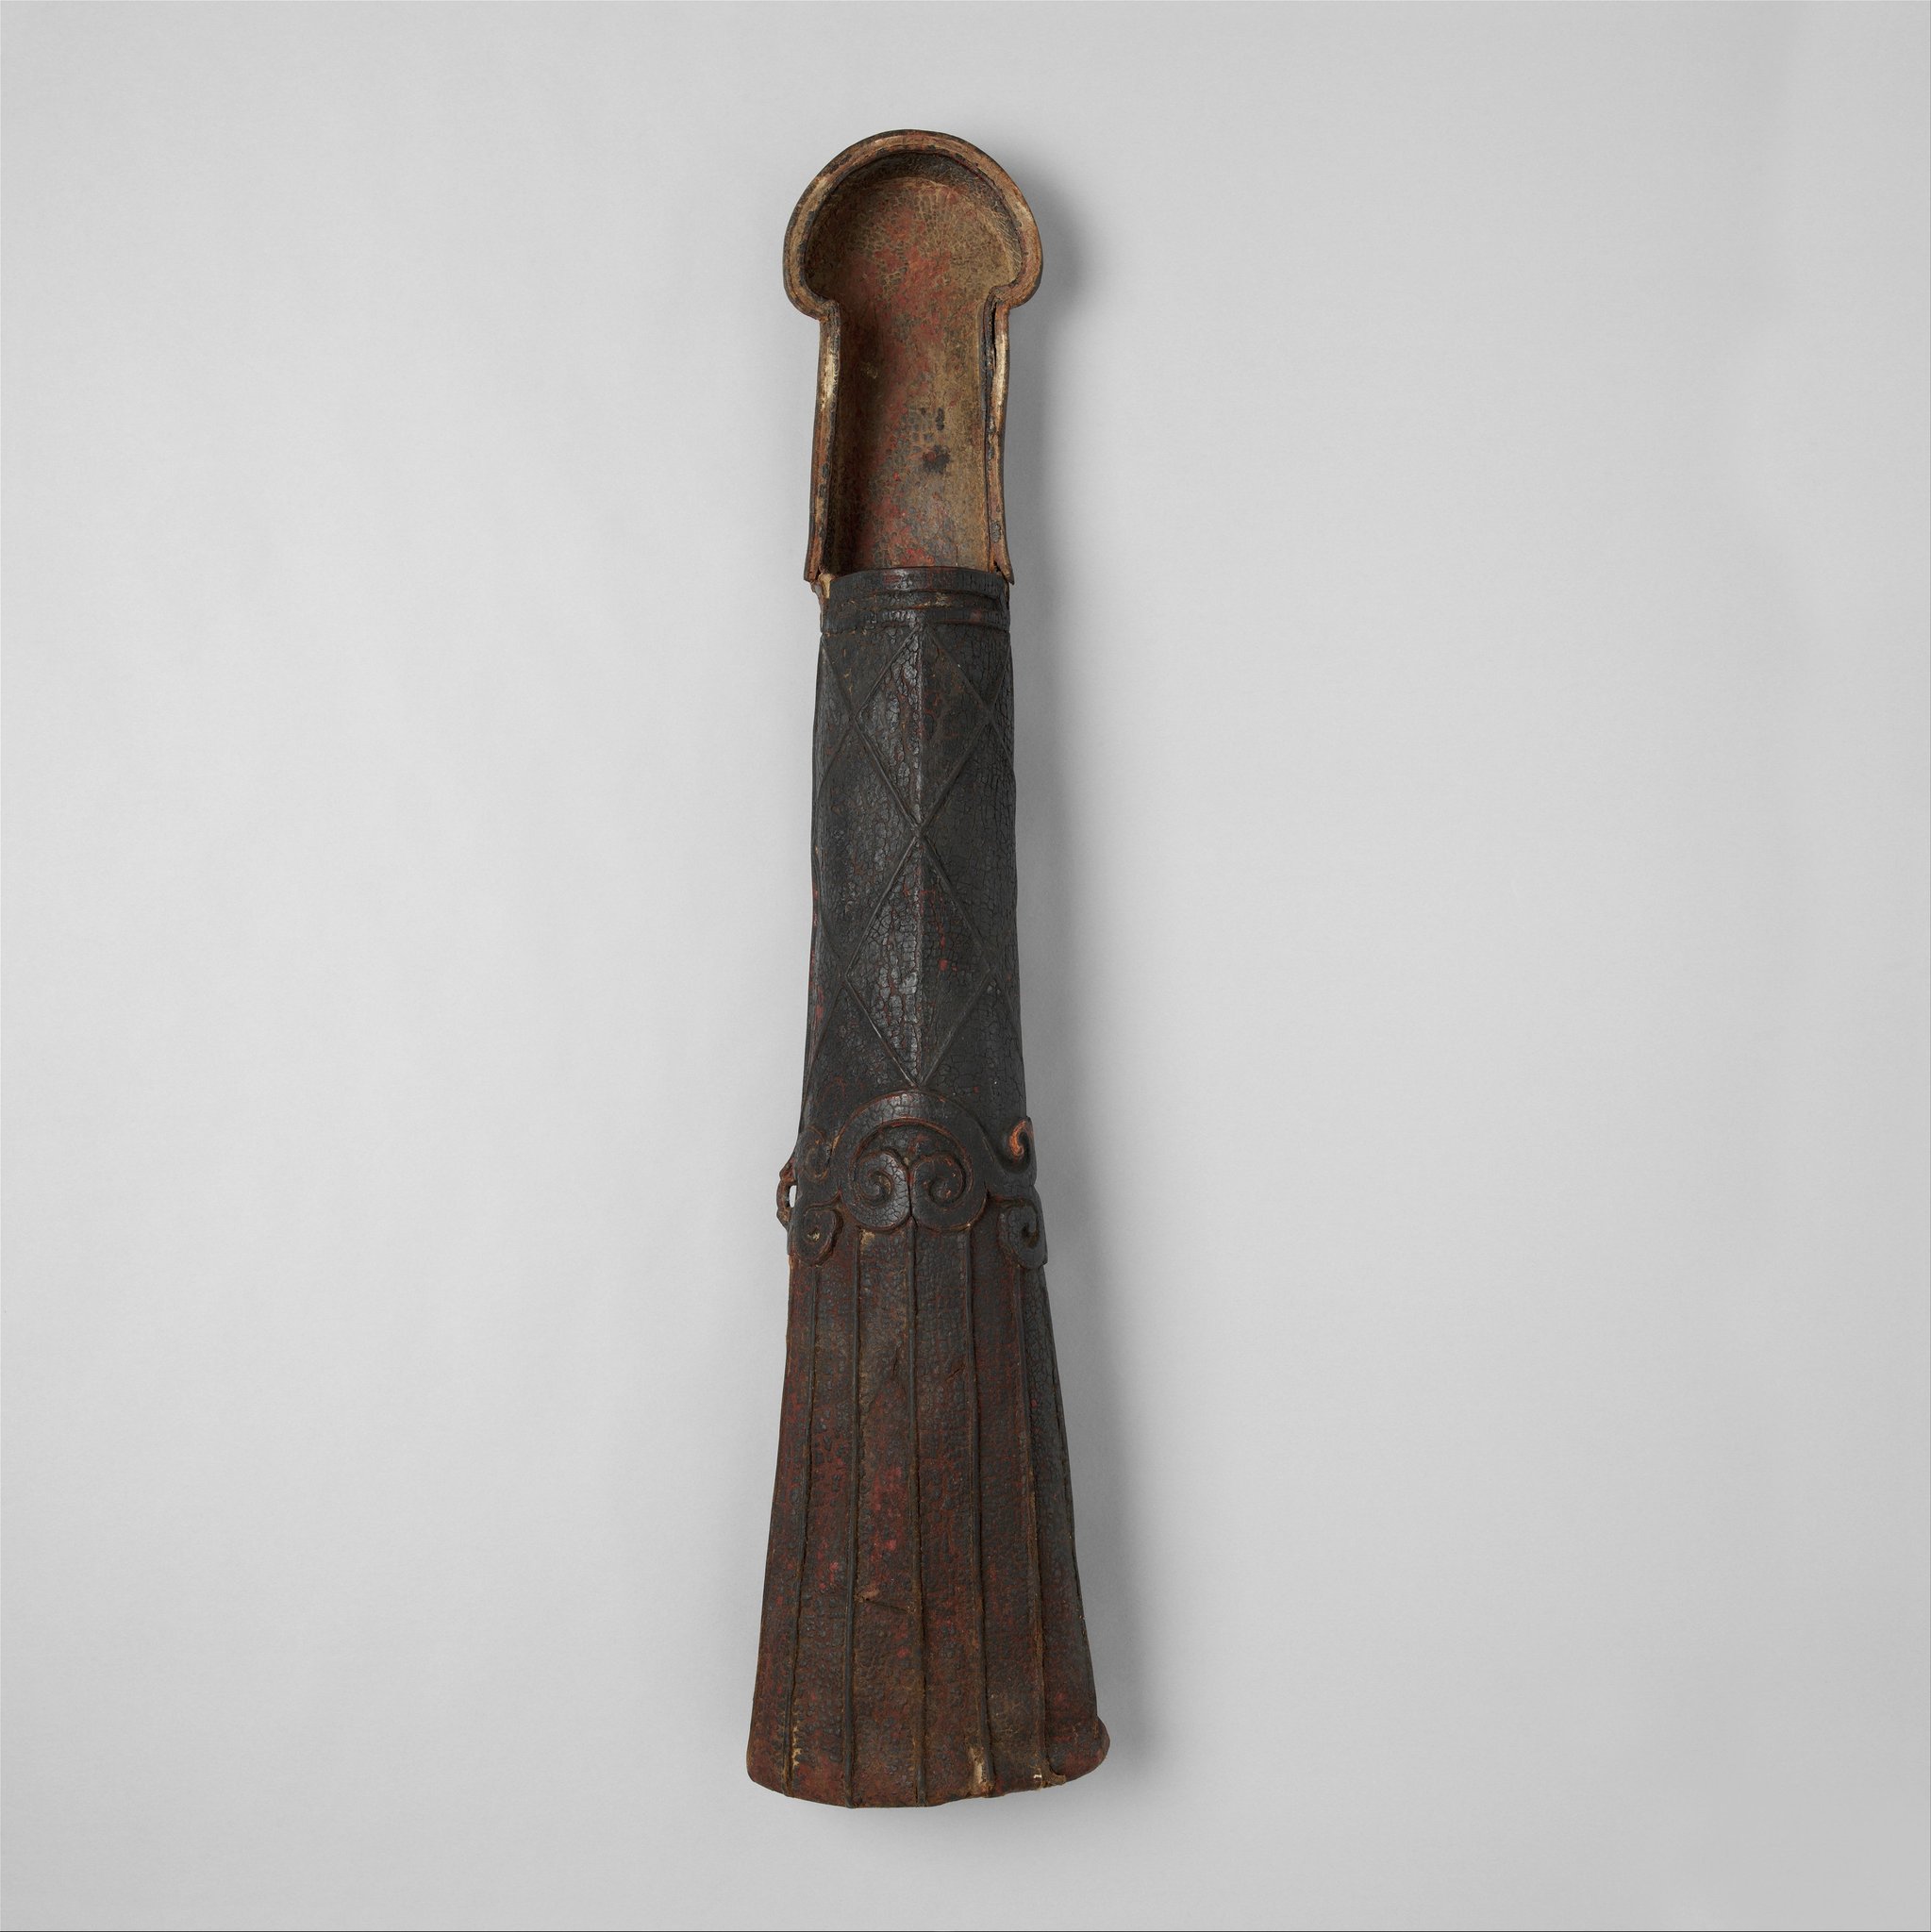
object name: quiver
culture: mongolian or tibetan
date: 1301-1500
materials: lacquer, leather, wood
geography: tibet